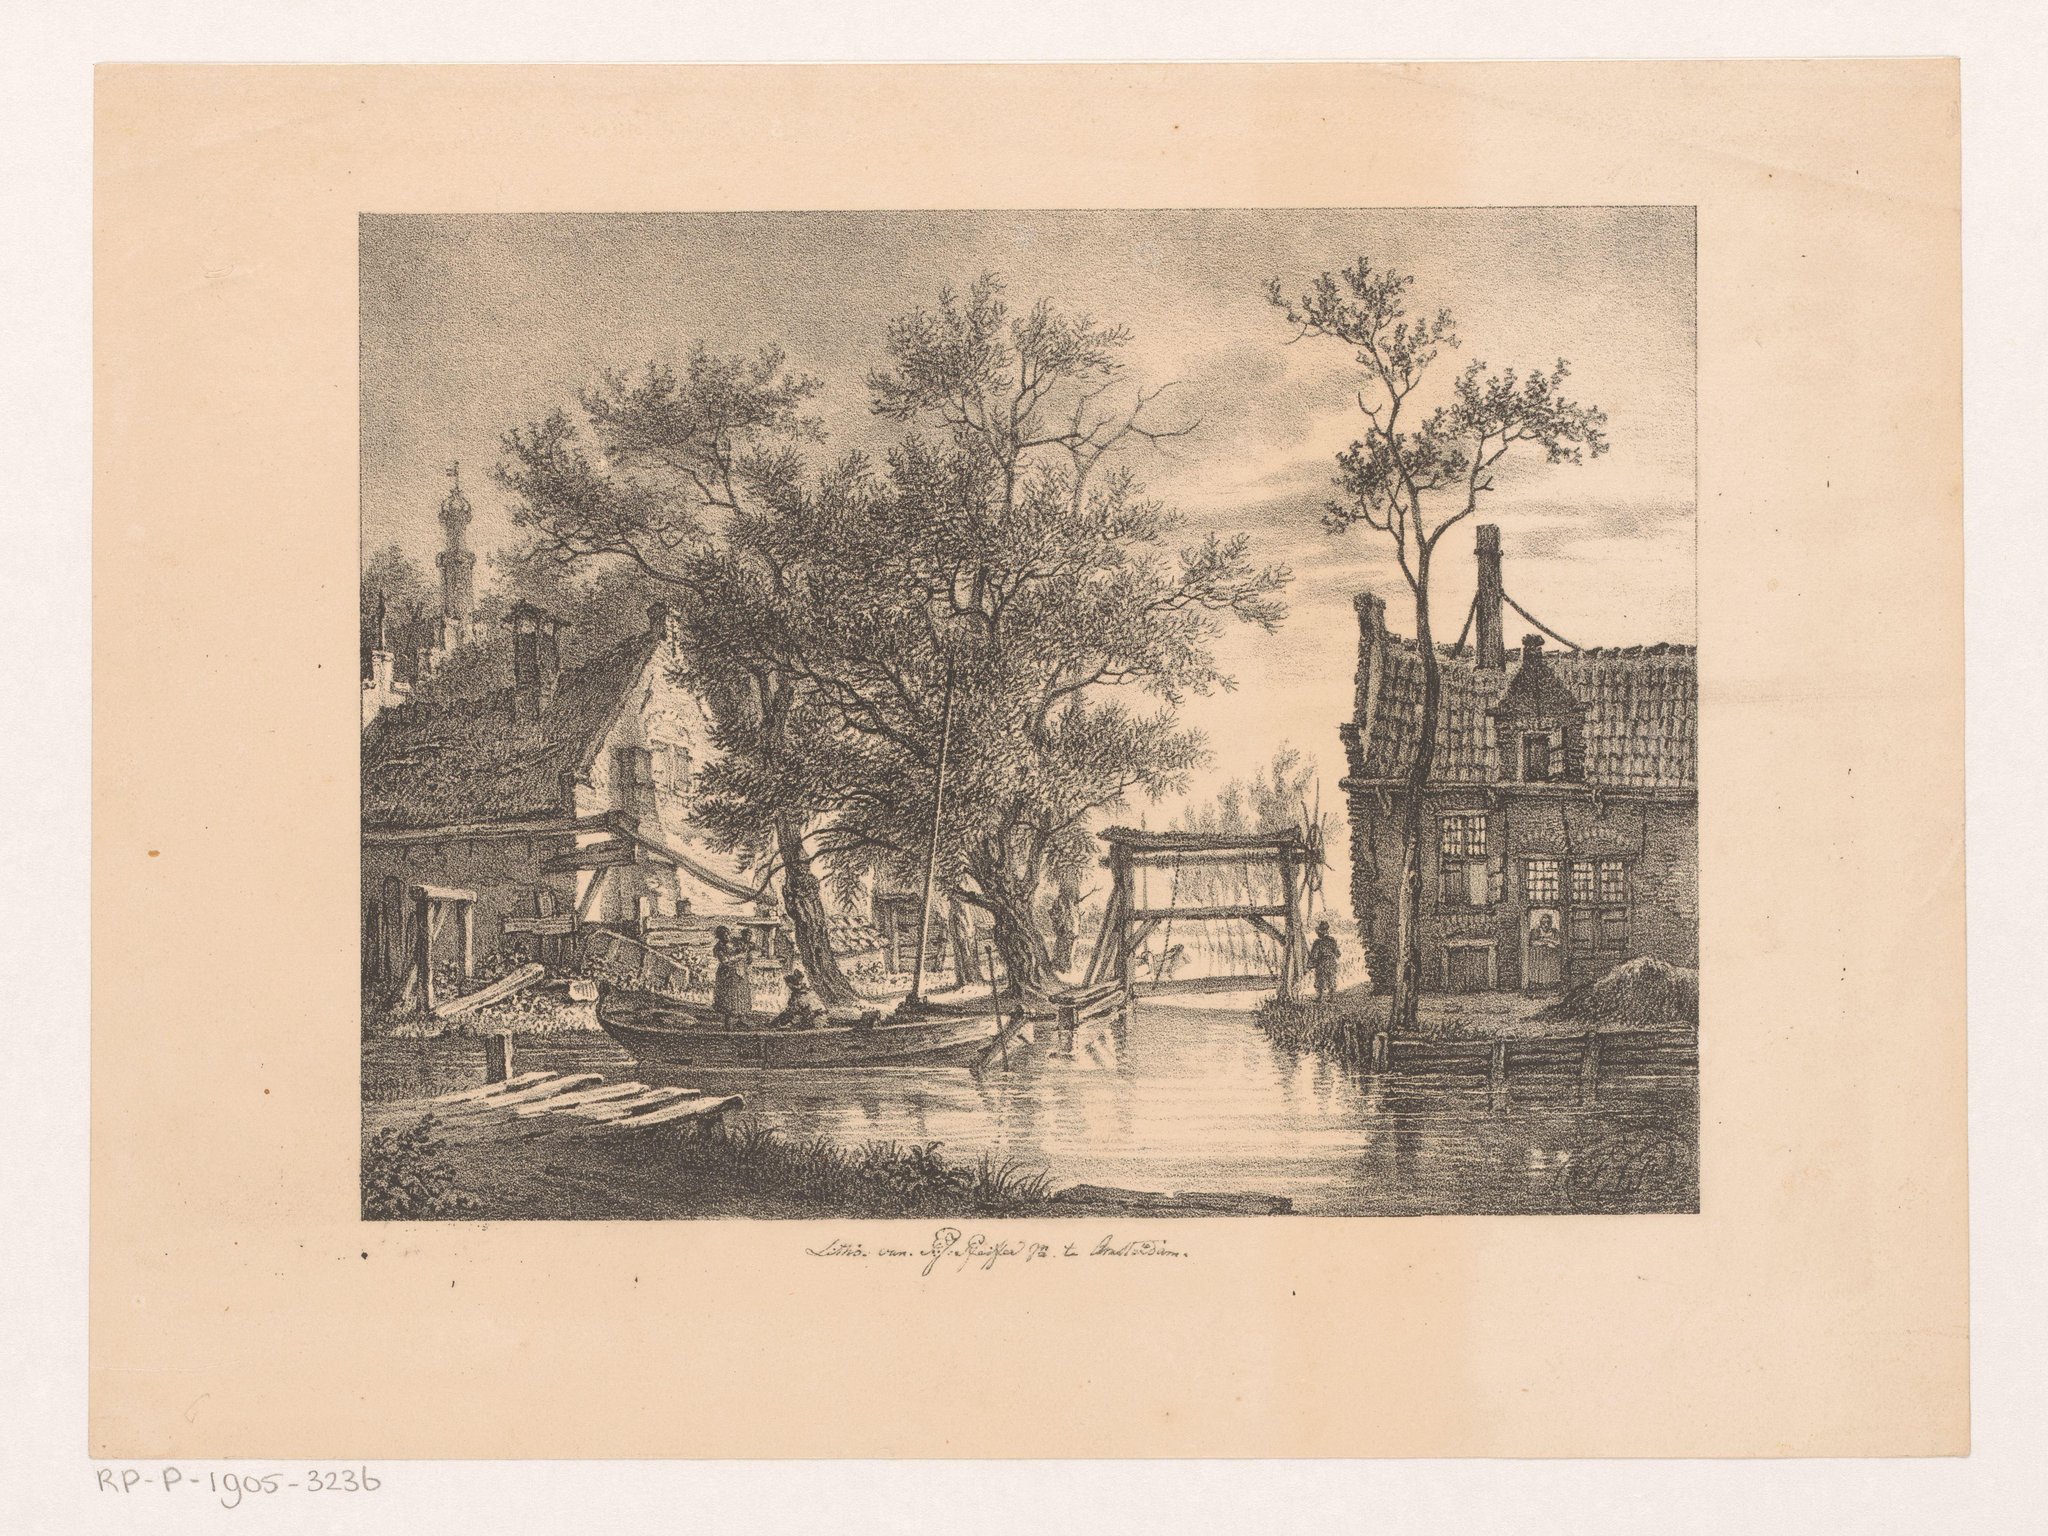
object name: print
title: Huizen aan een wetering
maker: françois joseph pfeiffer (ii)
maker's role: draughtsman, print maker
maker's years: 1778-1835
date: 1809-1835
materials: paper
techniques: lithograph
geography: amsterdam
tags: sluice, weir, water course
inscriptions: collector's mark: Lugt 2228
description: Dorpsgezicht met huizen aan het water met een sluis. Op het water vaart een boot.